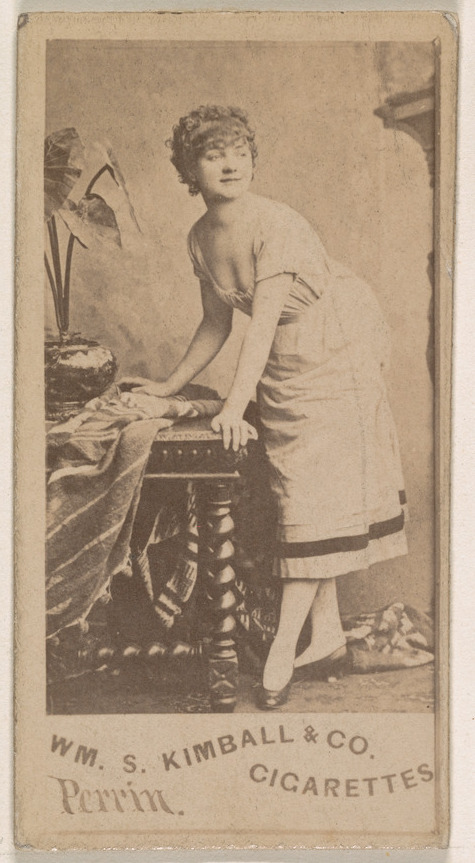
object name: photograph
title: Miss Perrin, from the Actresses series (N203) issued by Wm. S. Kimball & Co.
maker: william s. kimball & company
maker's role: publisher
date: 1889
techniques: color lithograph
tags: portraits,women,actresses